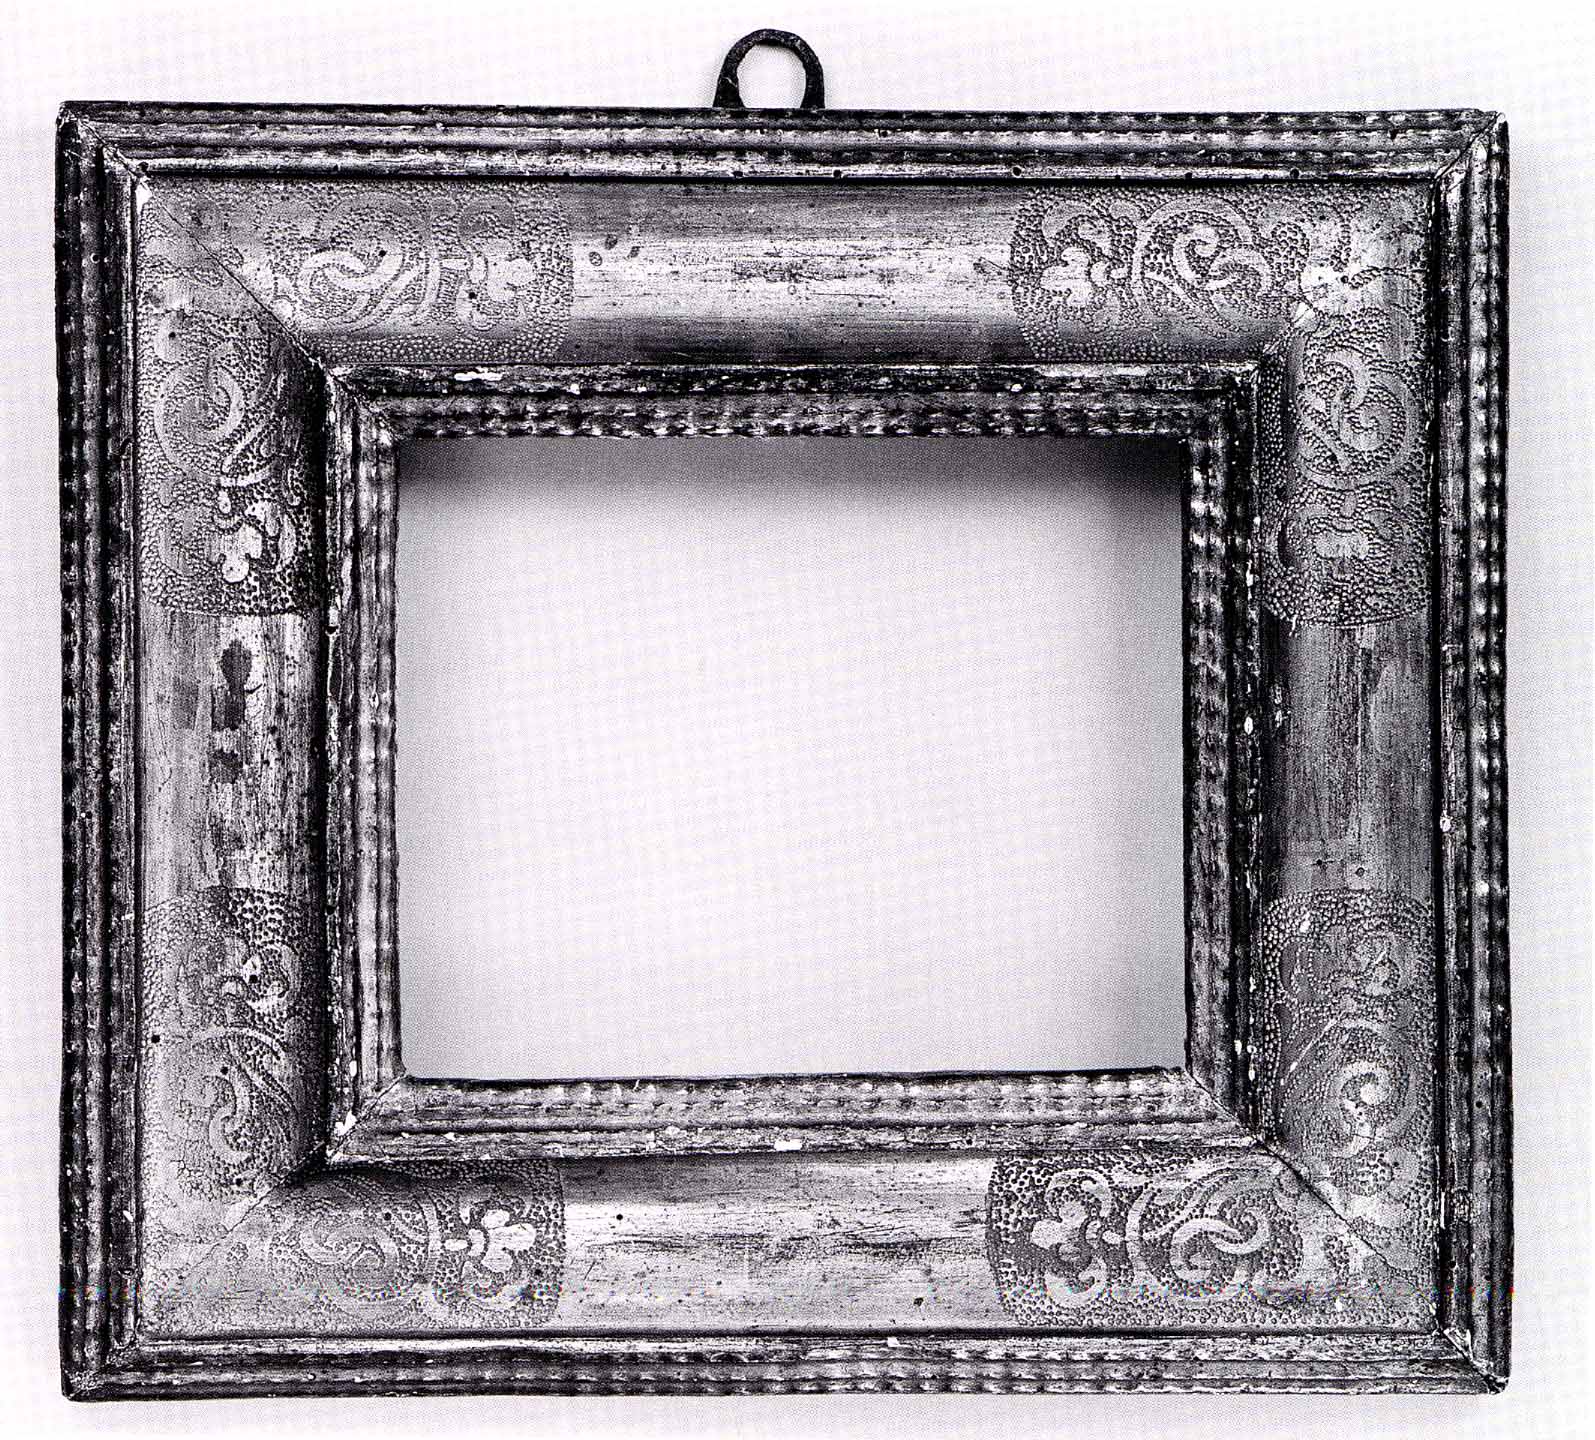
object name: frame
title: Gilt ripple frame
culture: sicilian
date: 1667-1700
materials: gilt, iron, wood